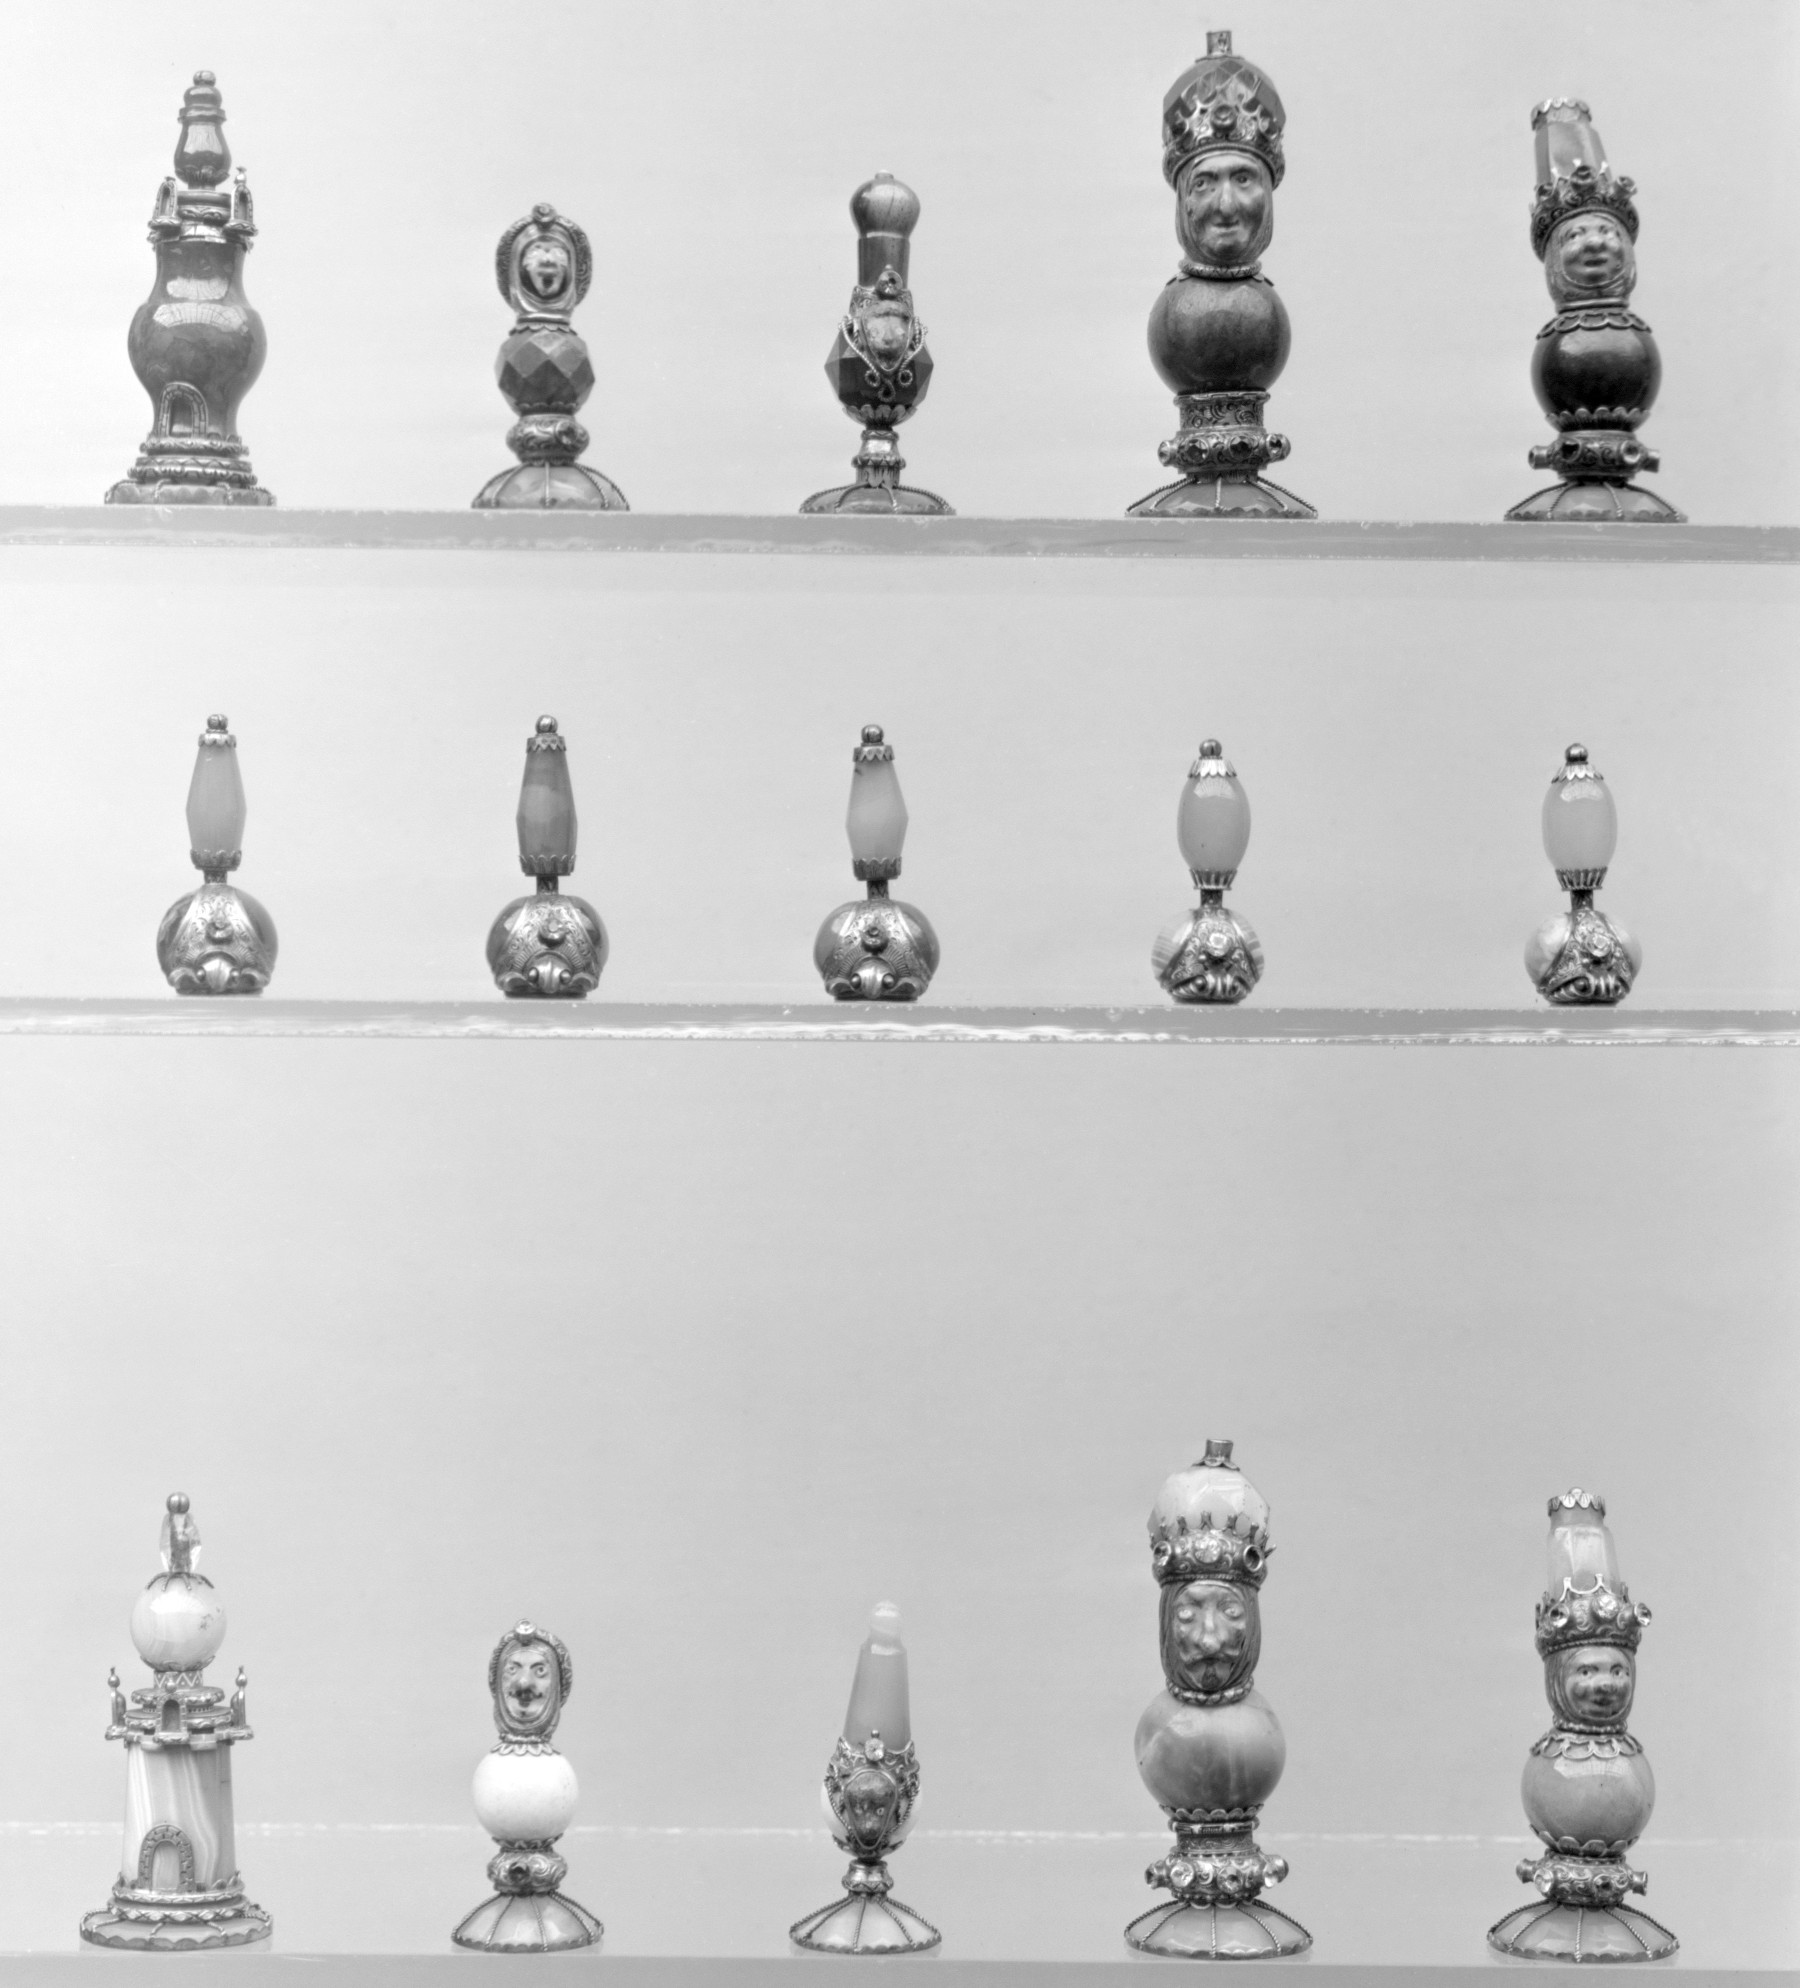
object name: chessman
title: Chessmen (32) in box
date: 1701-1800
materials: stone, gemstone, enamel, leather, silver gilt, velvet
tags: chess